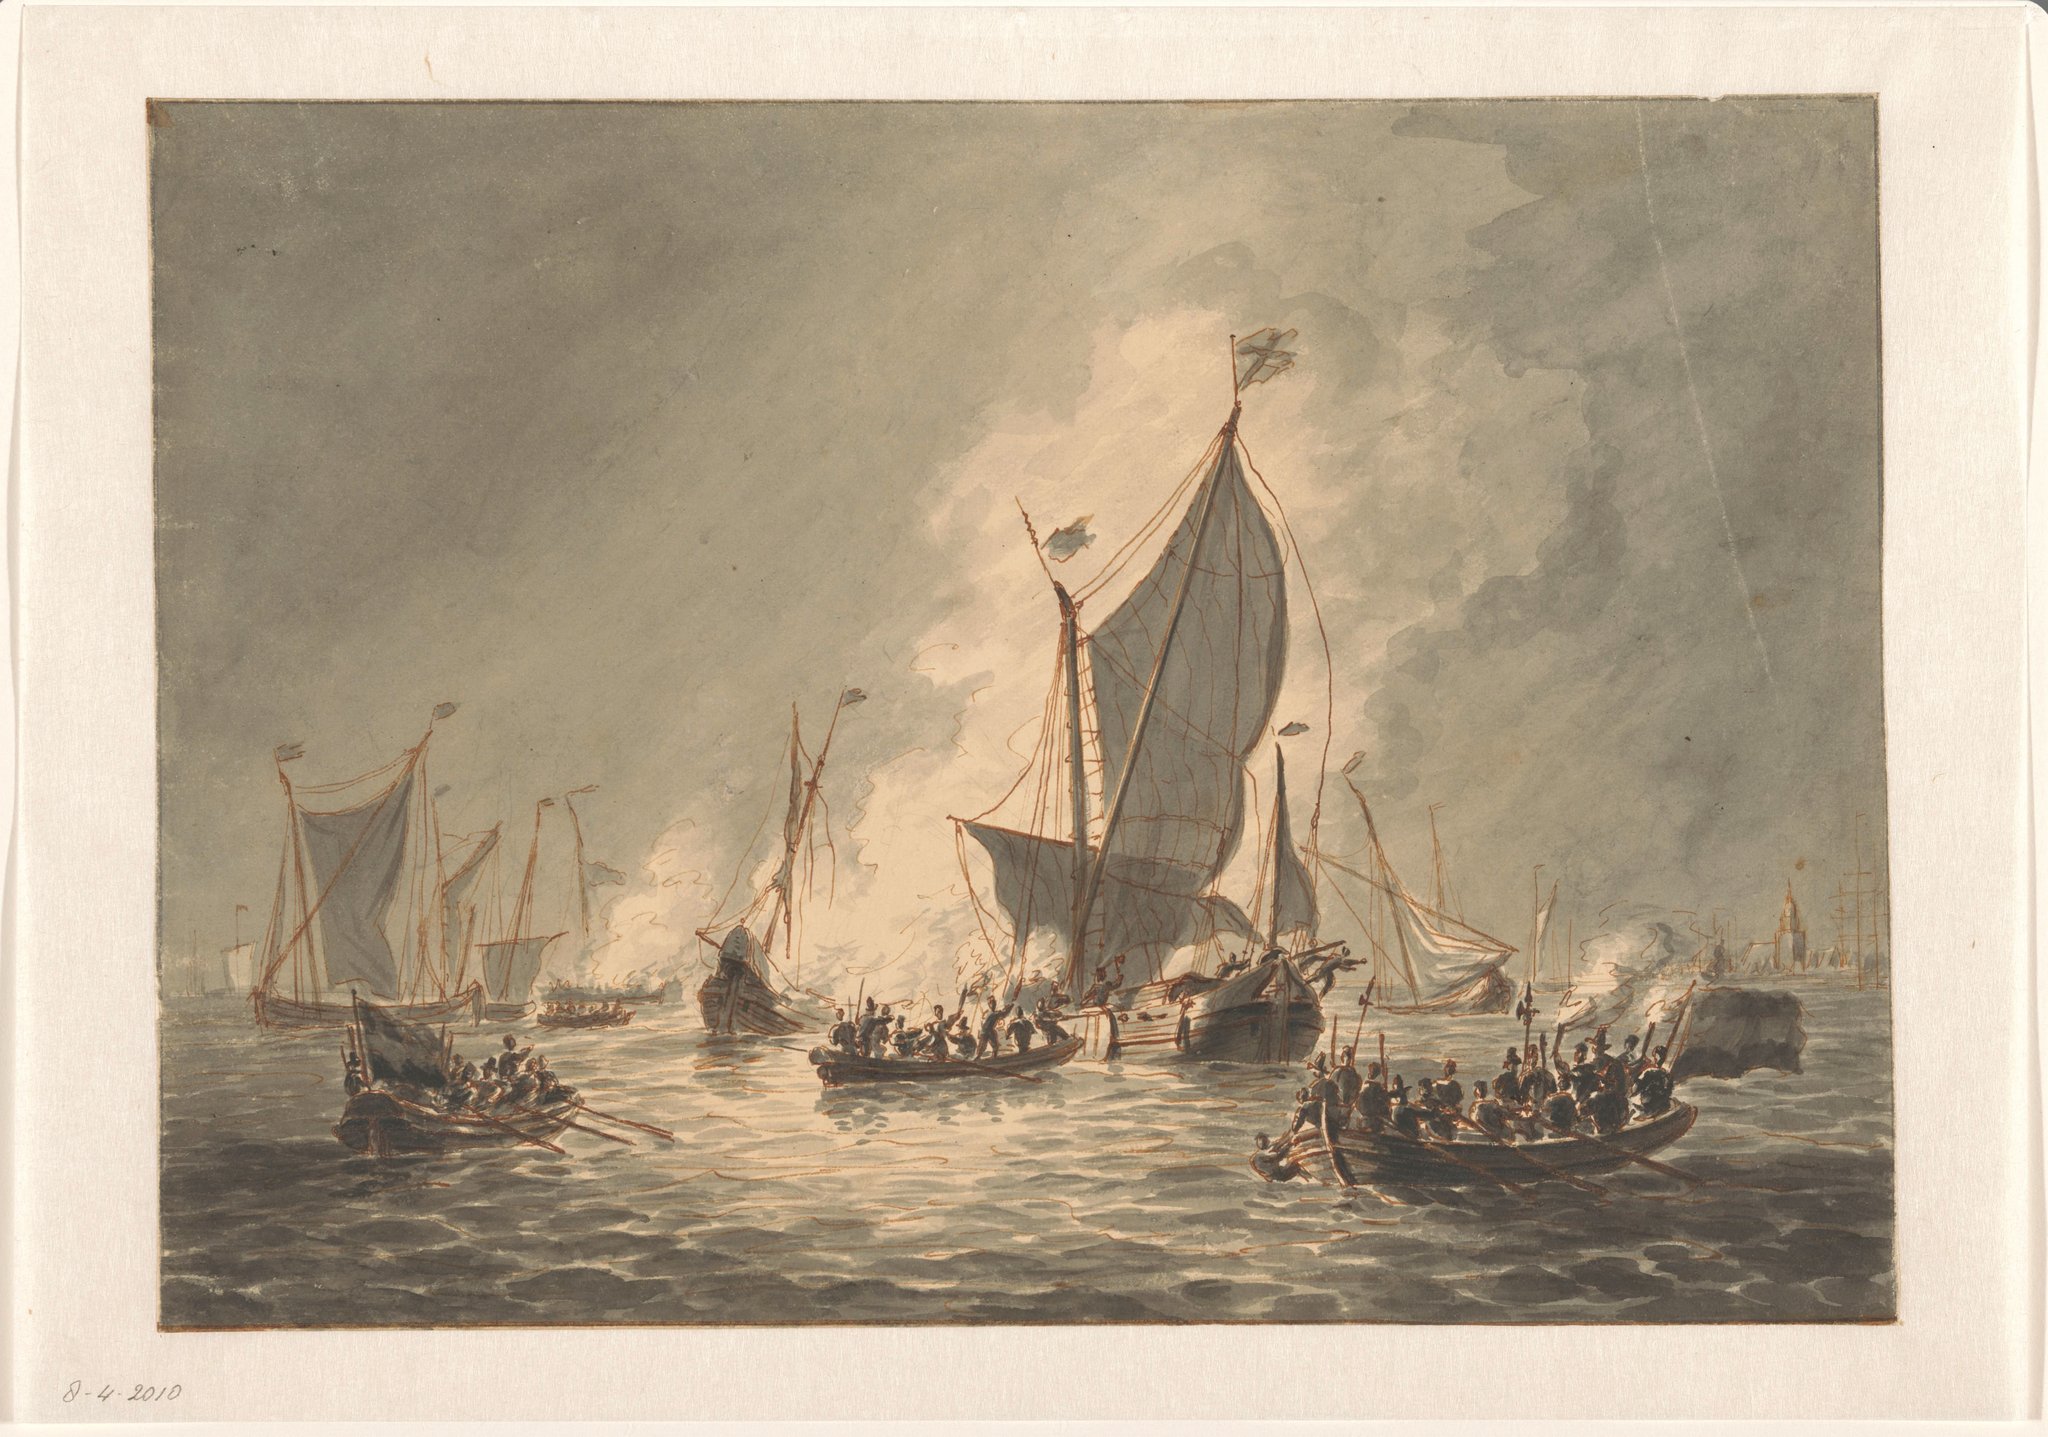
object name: drawing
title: Vernielen en verbranden door de Watergeuzen van de Spaanse schepen bij Den Briel, 1572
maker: hendrik vettewinkel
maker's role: draughtsman, painter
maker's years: 1809-1878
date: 1832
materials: ink, paper, pencil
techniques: brush, pen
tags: battle (+ naval force), ships (in general) - cc - more than one ship, historical events and situations, sea, brielle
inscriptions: date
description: Het vernielen en verbranden door de Watergeuzen onder Treslong en Roobol van de vaartuigen waarmee de Spanjaarden geland waren ter herneming van Den Briel, 5 april 1572.